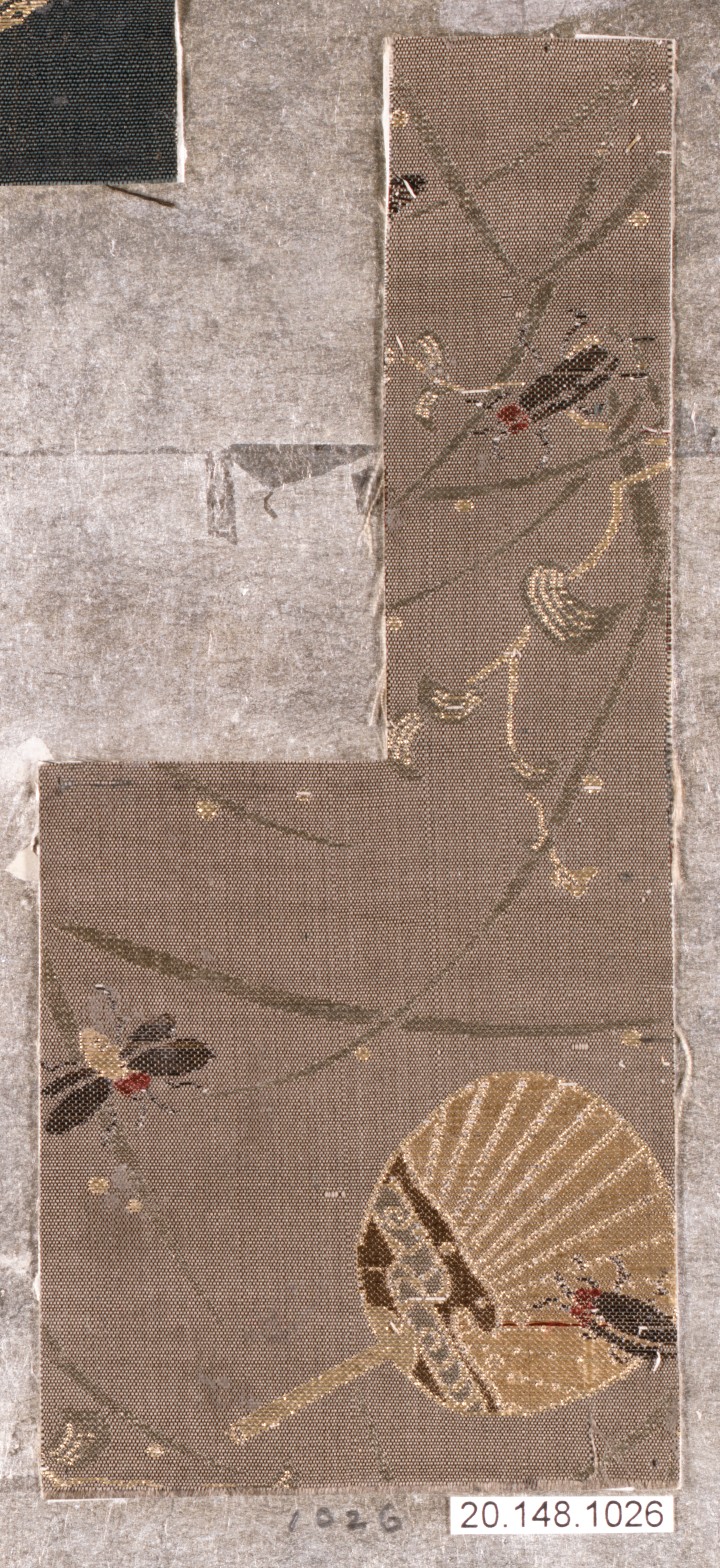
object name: piece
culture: japanese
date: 1701-1800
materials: silk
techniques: compound weave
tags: fans,insects,dragonflies